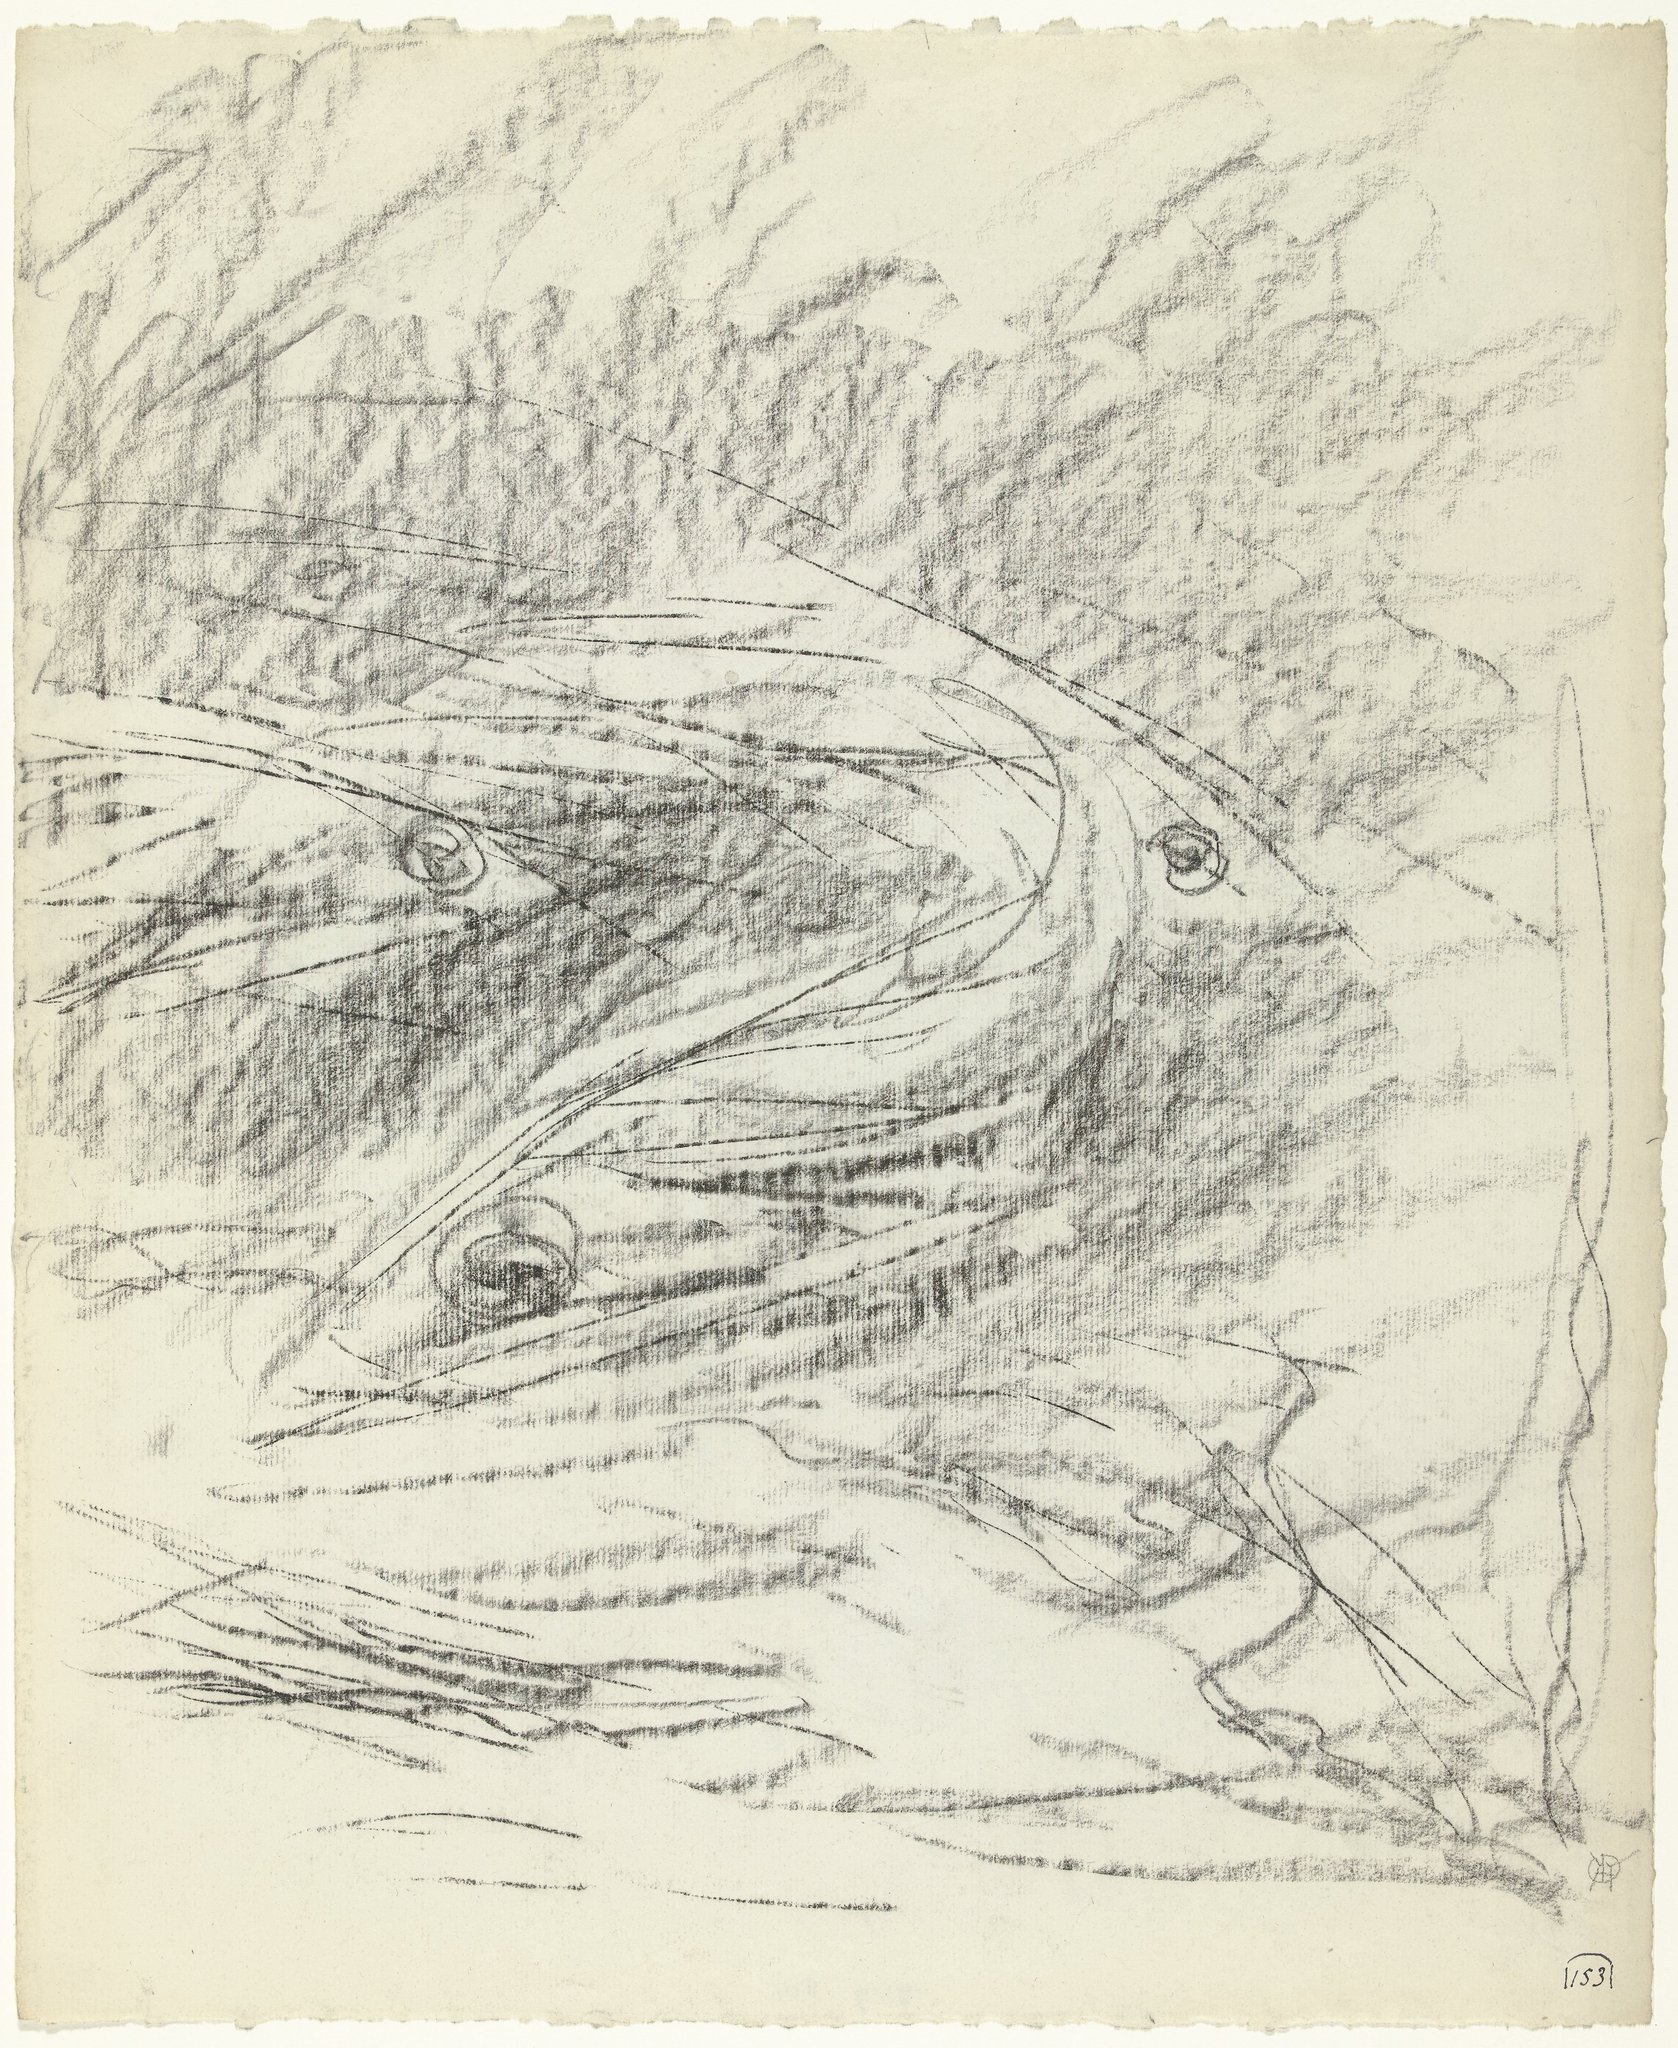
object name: drawing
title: Schets met vissen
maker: gerrit willem dijsselhof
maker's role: designer, draughtsman, print maker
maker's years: 1866-1924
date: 1876-1924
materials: chalk, paper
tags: bony fishes